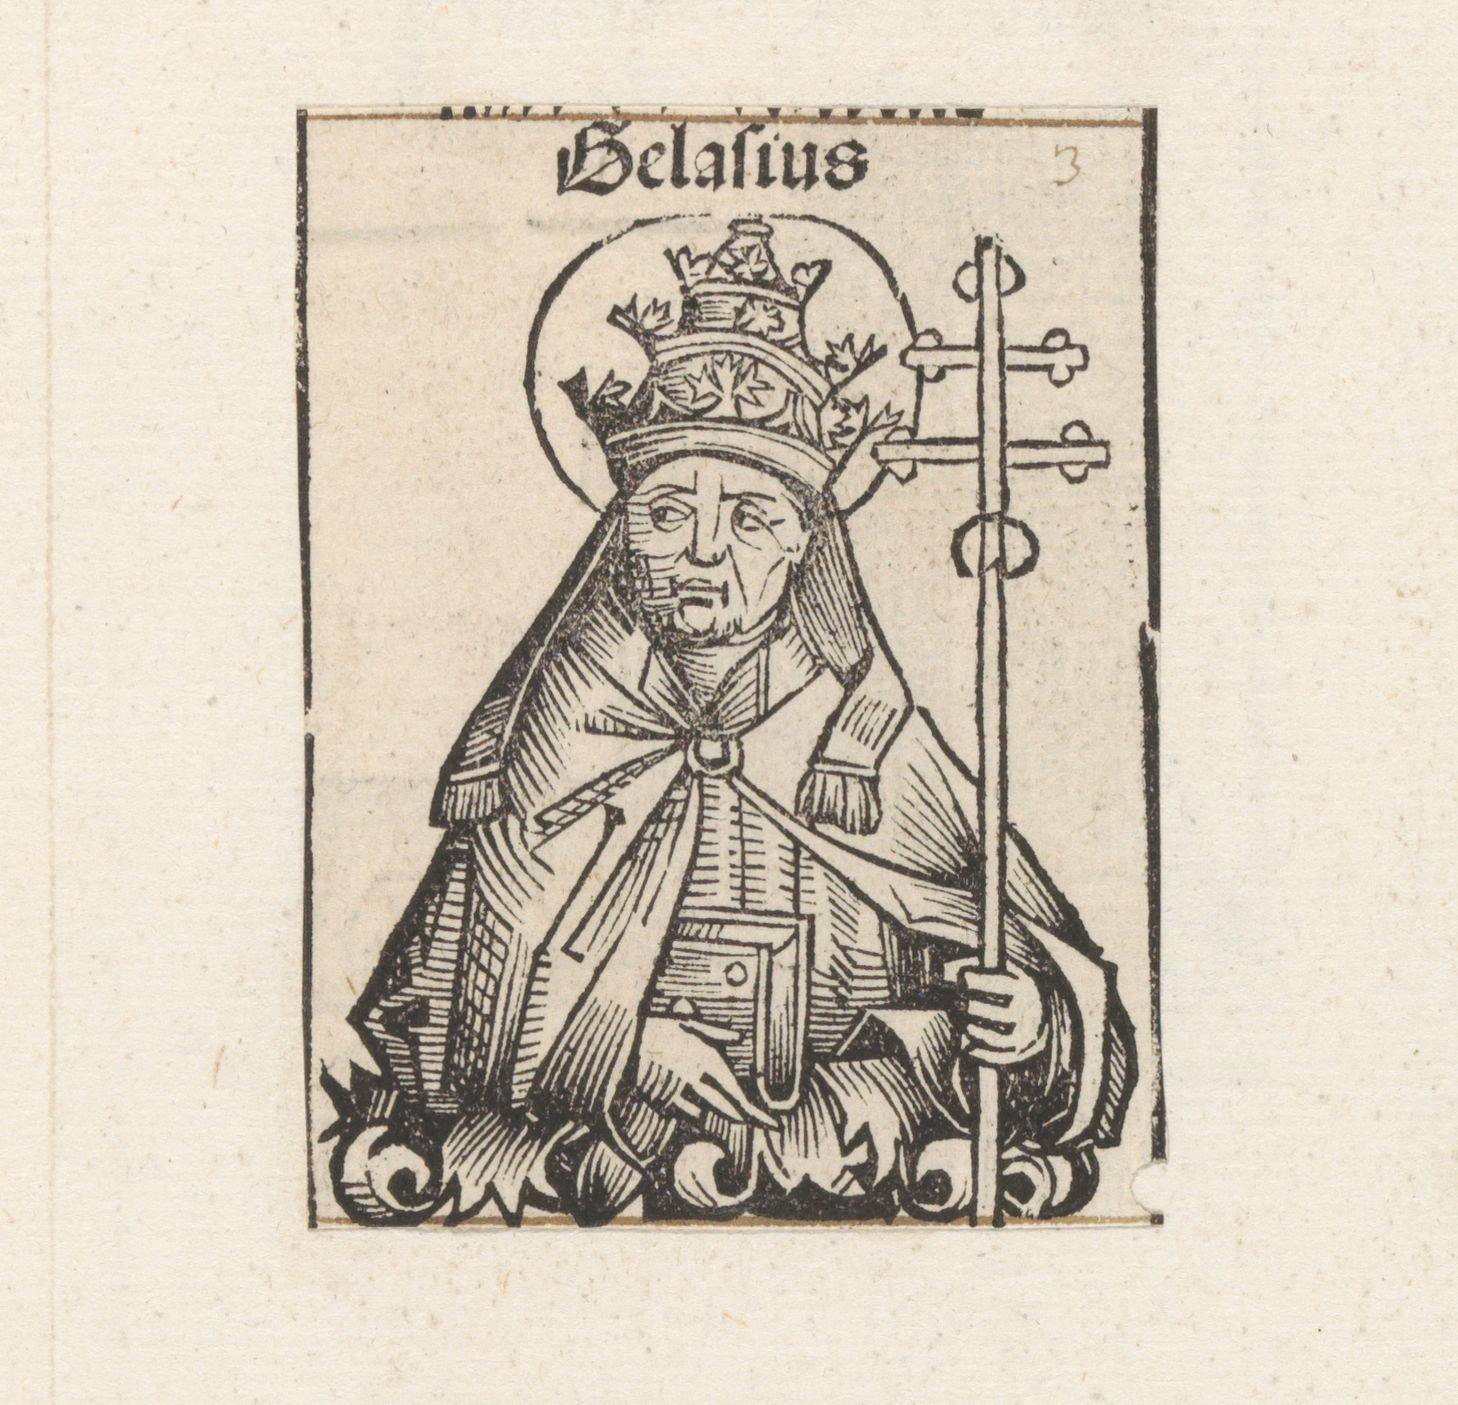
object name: book illustration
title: Gelasius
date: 1493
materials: paper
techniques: letterpress printing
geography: nuremberg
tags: pope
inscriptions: inscription: ‘3’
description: Een bloemkelk met een paus. Hij draagt een tiara en heeft een bijbel en staf met een dubbel kruis in zijn handen. De nimbus om zijn hoofd vertelt dat deze paus heilig is verklaard. De voorstelling is onderdeel van de opeenvolging pausen in de Liber Chronicarum. De tekst identificeert de man als paus Gelasius I. De prent maakt deel uit van een album.